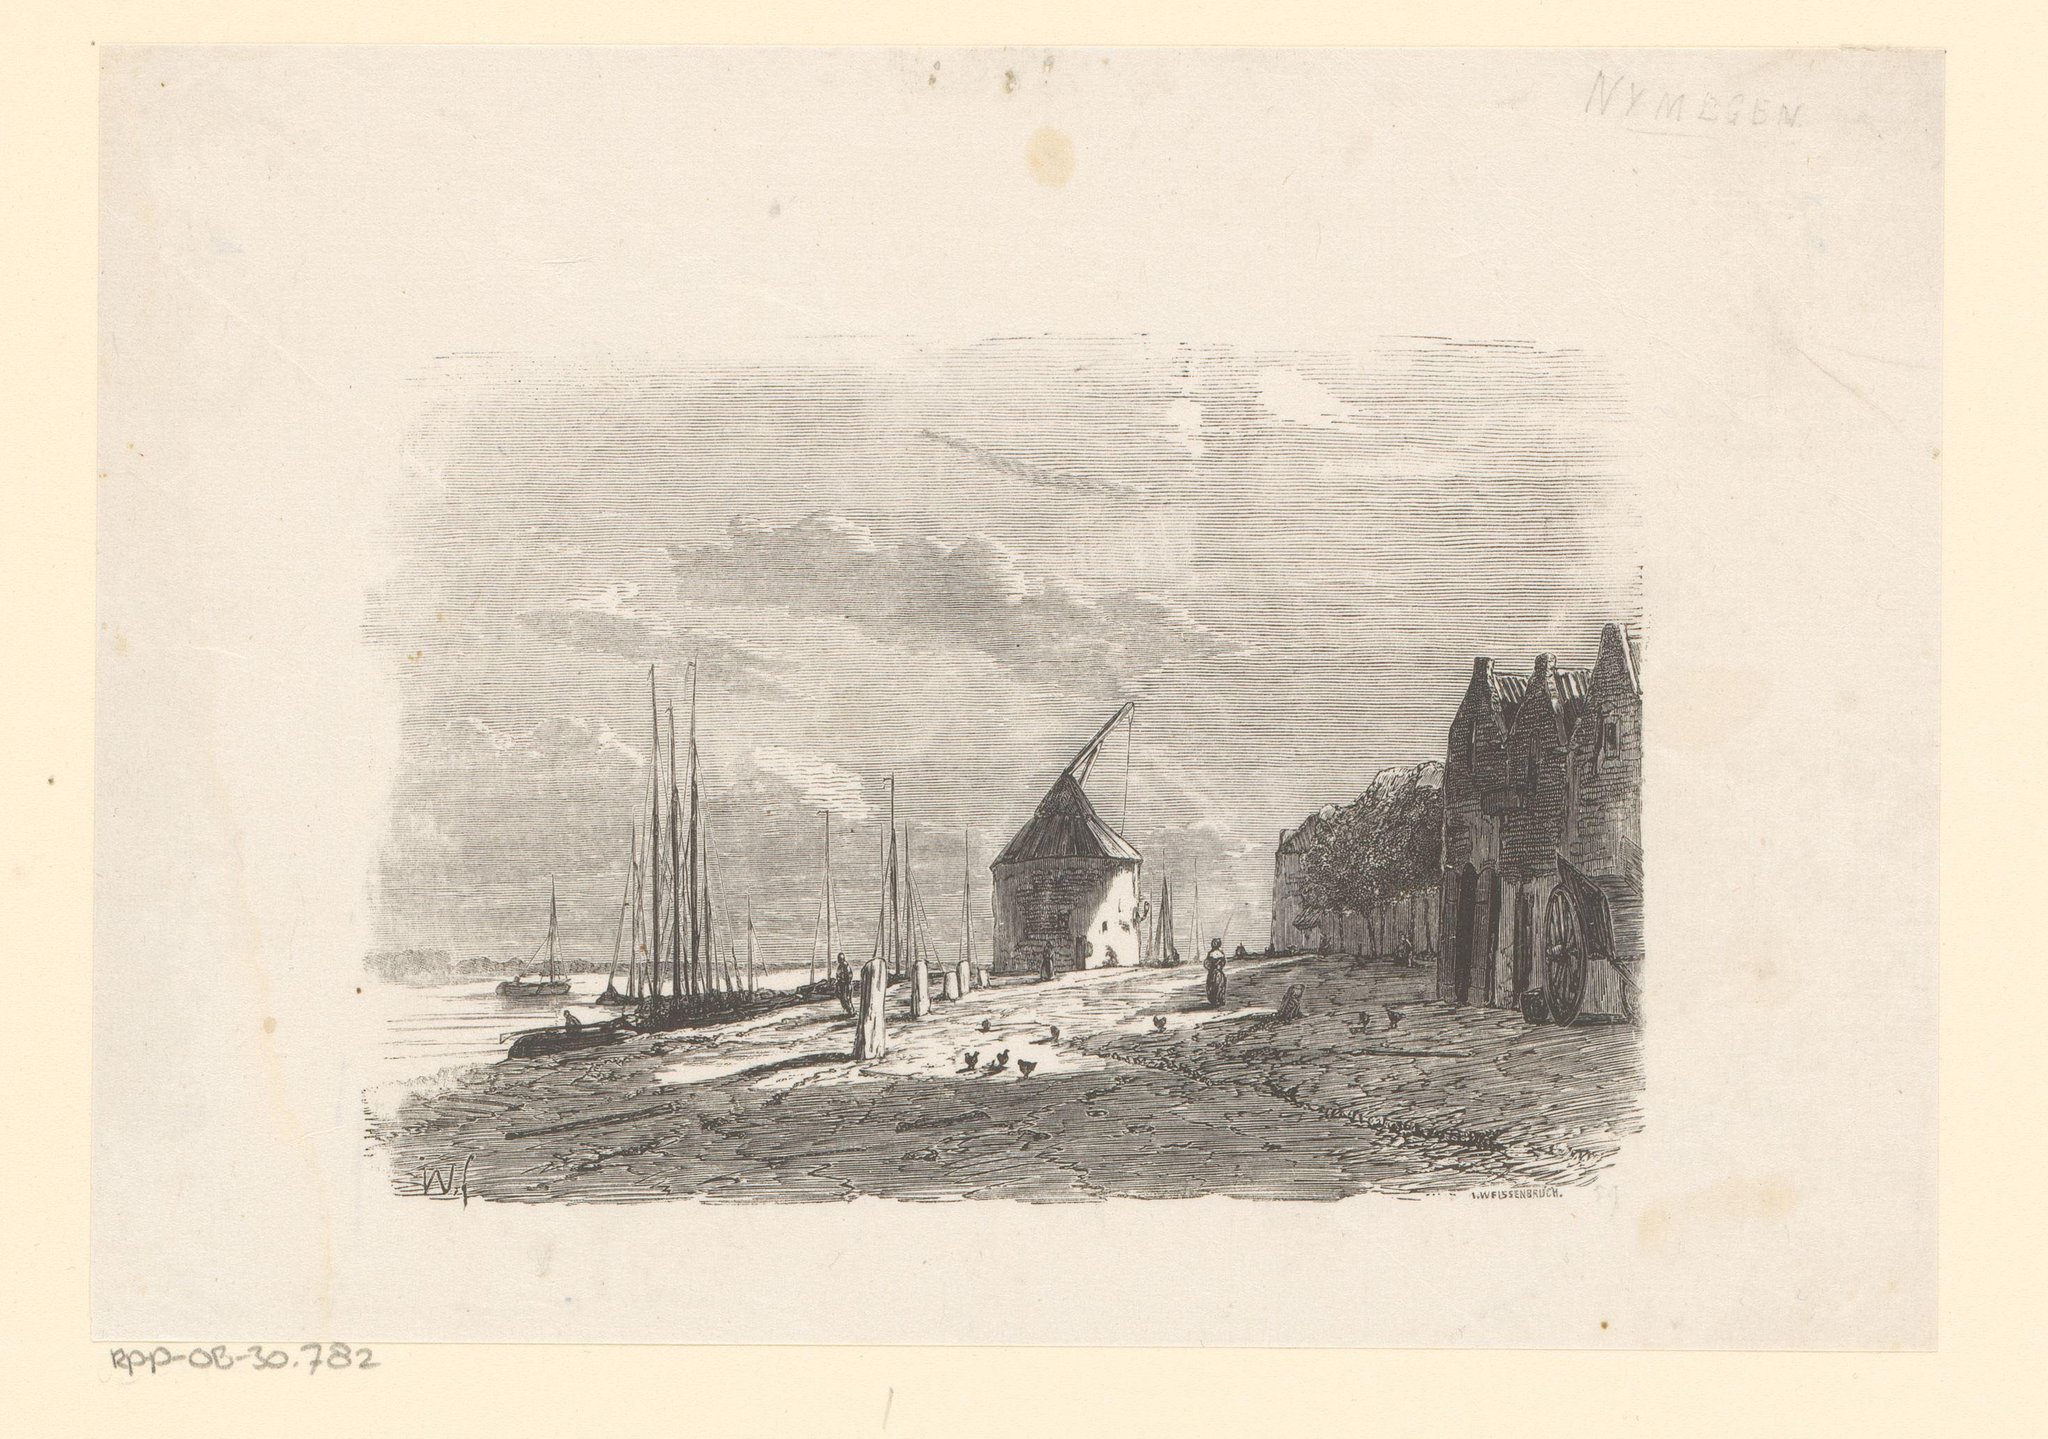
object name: print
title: Strandgezicht met huizen aan het water en schepen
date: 1836-1912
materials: paper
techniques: engraving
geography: netherlands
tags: city-view, and landscape with man-made constructions, ships (in general) - cc - more than one ship, landscapes with waters, waterscapes, seascapes (in the temperate zone) (+ landscape with figures, staffage)